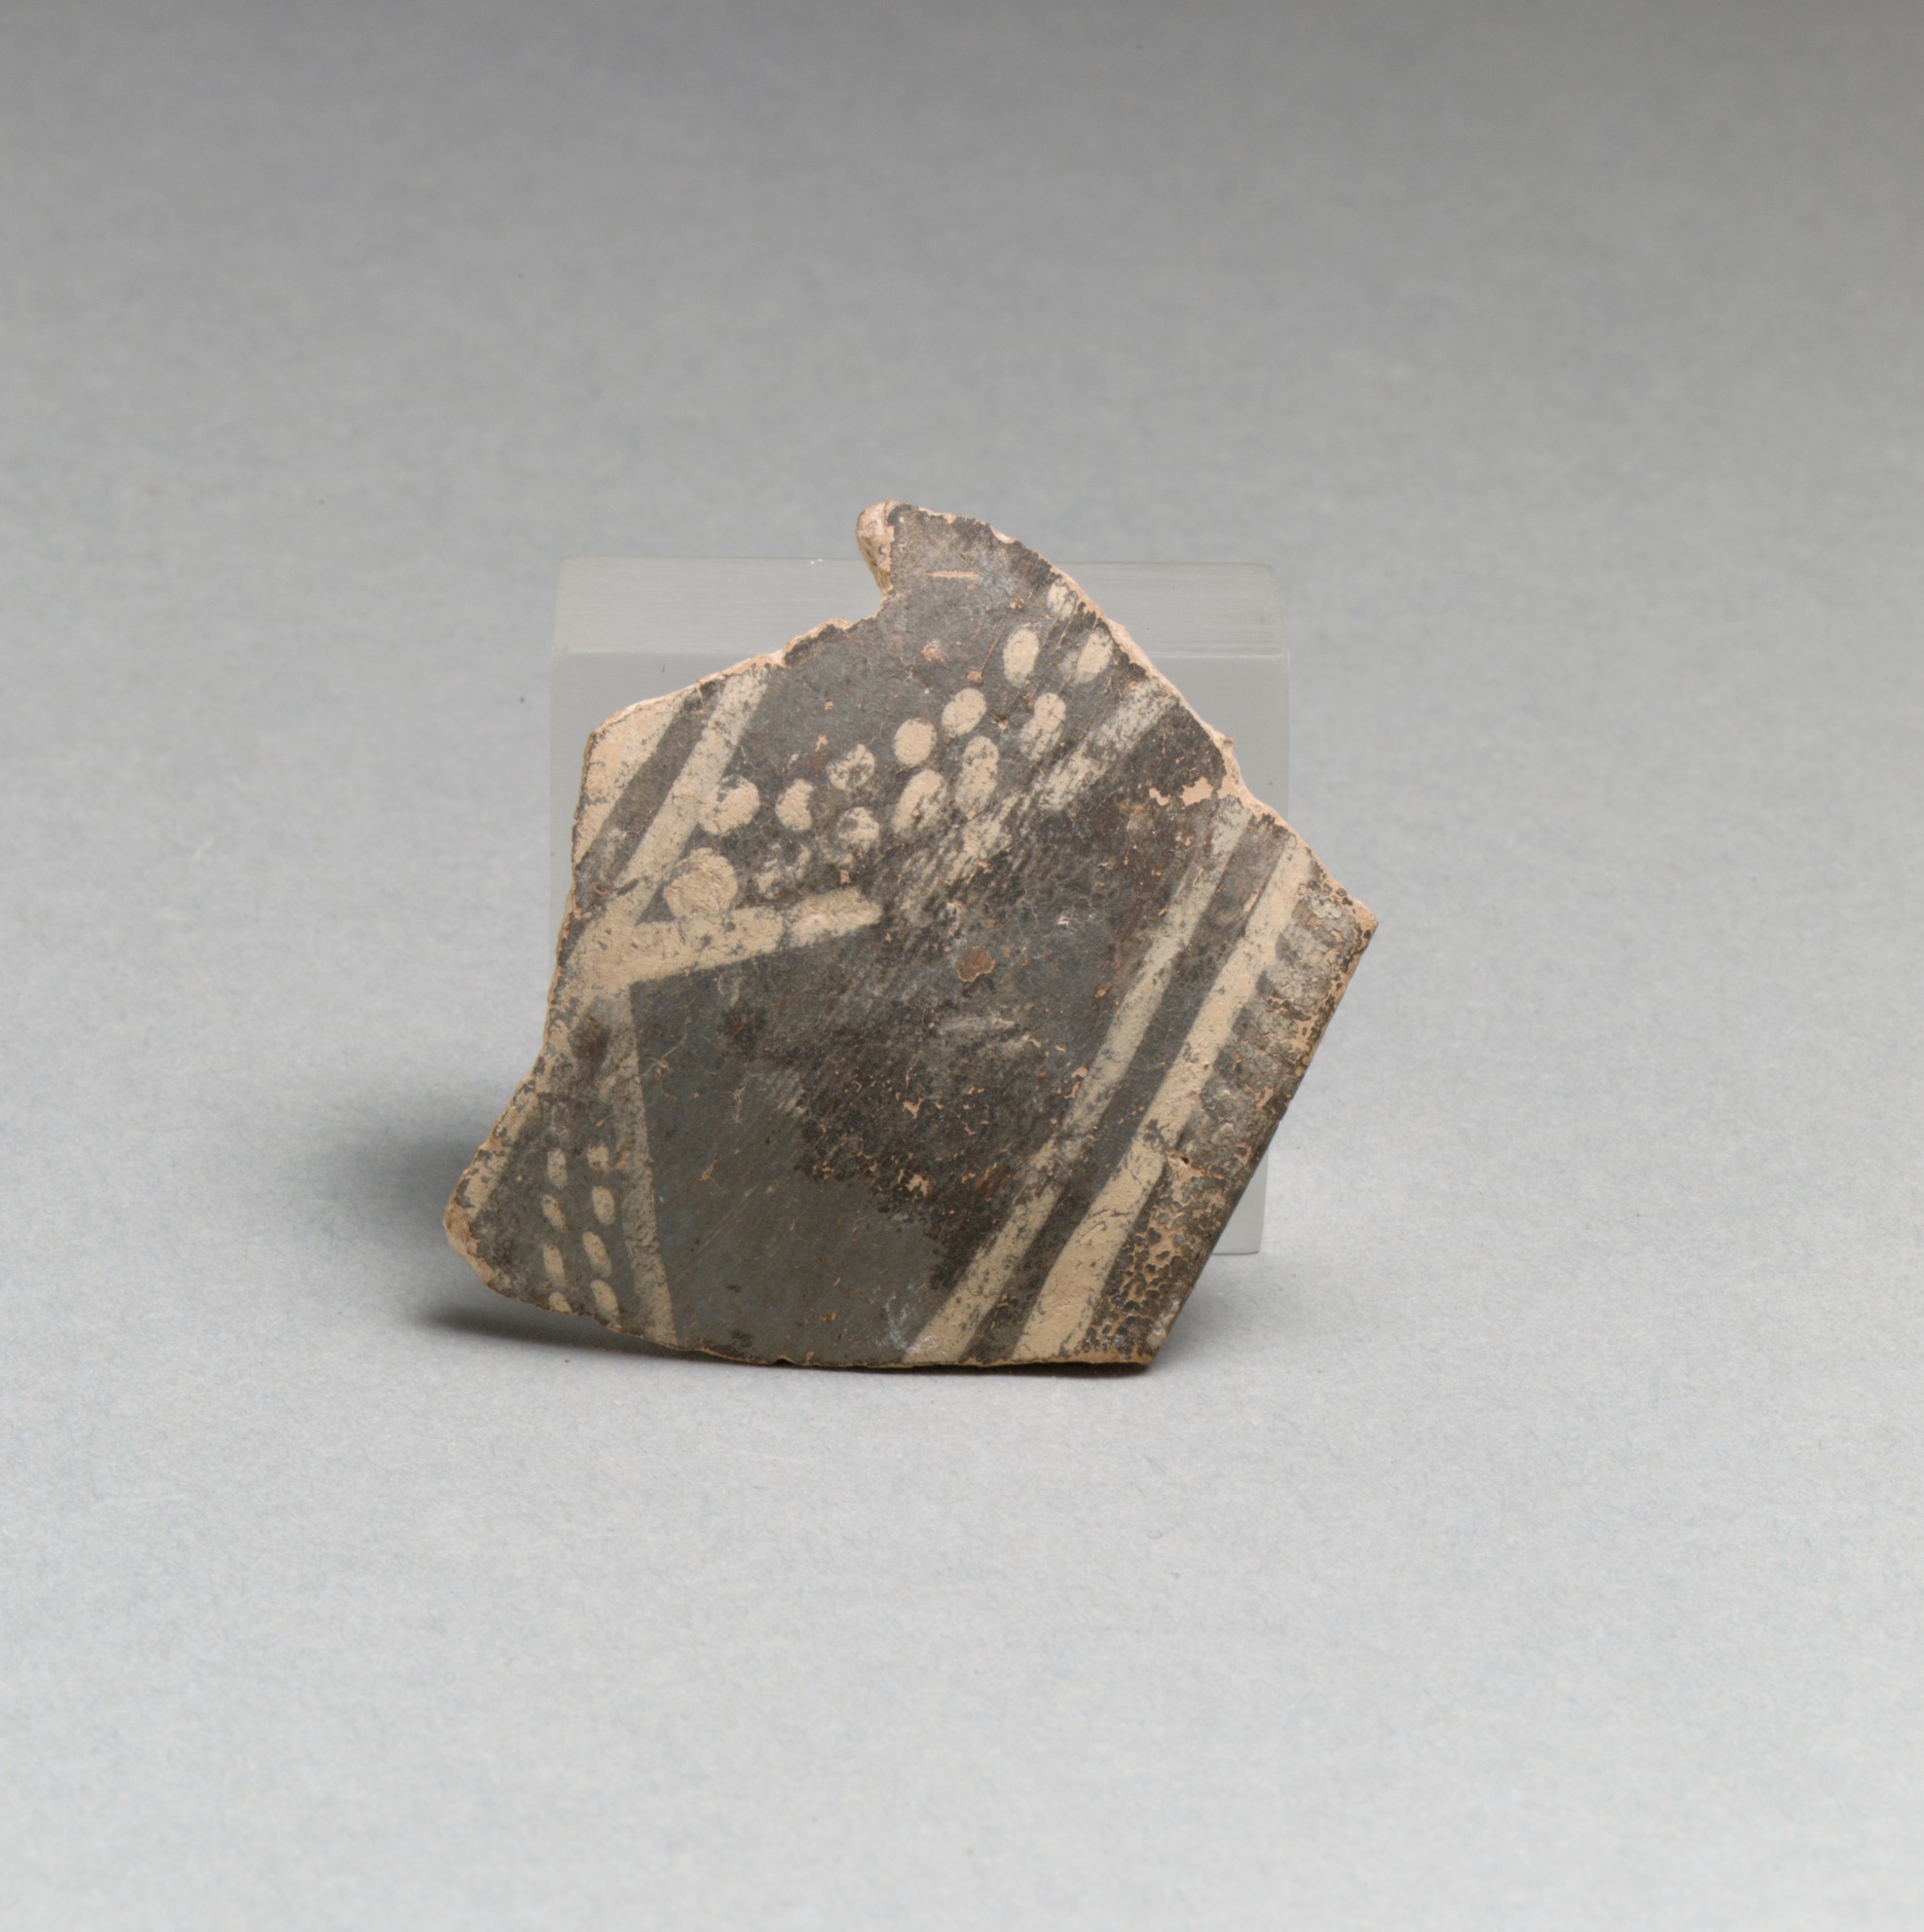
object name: vase fragment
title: Terracotta rim fragment with bands and dots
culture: minoan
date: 2300-2100 BCE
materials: terracotta